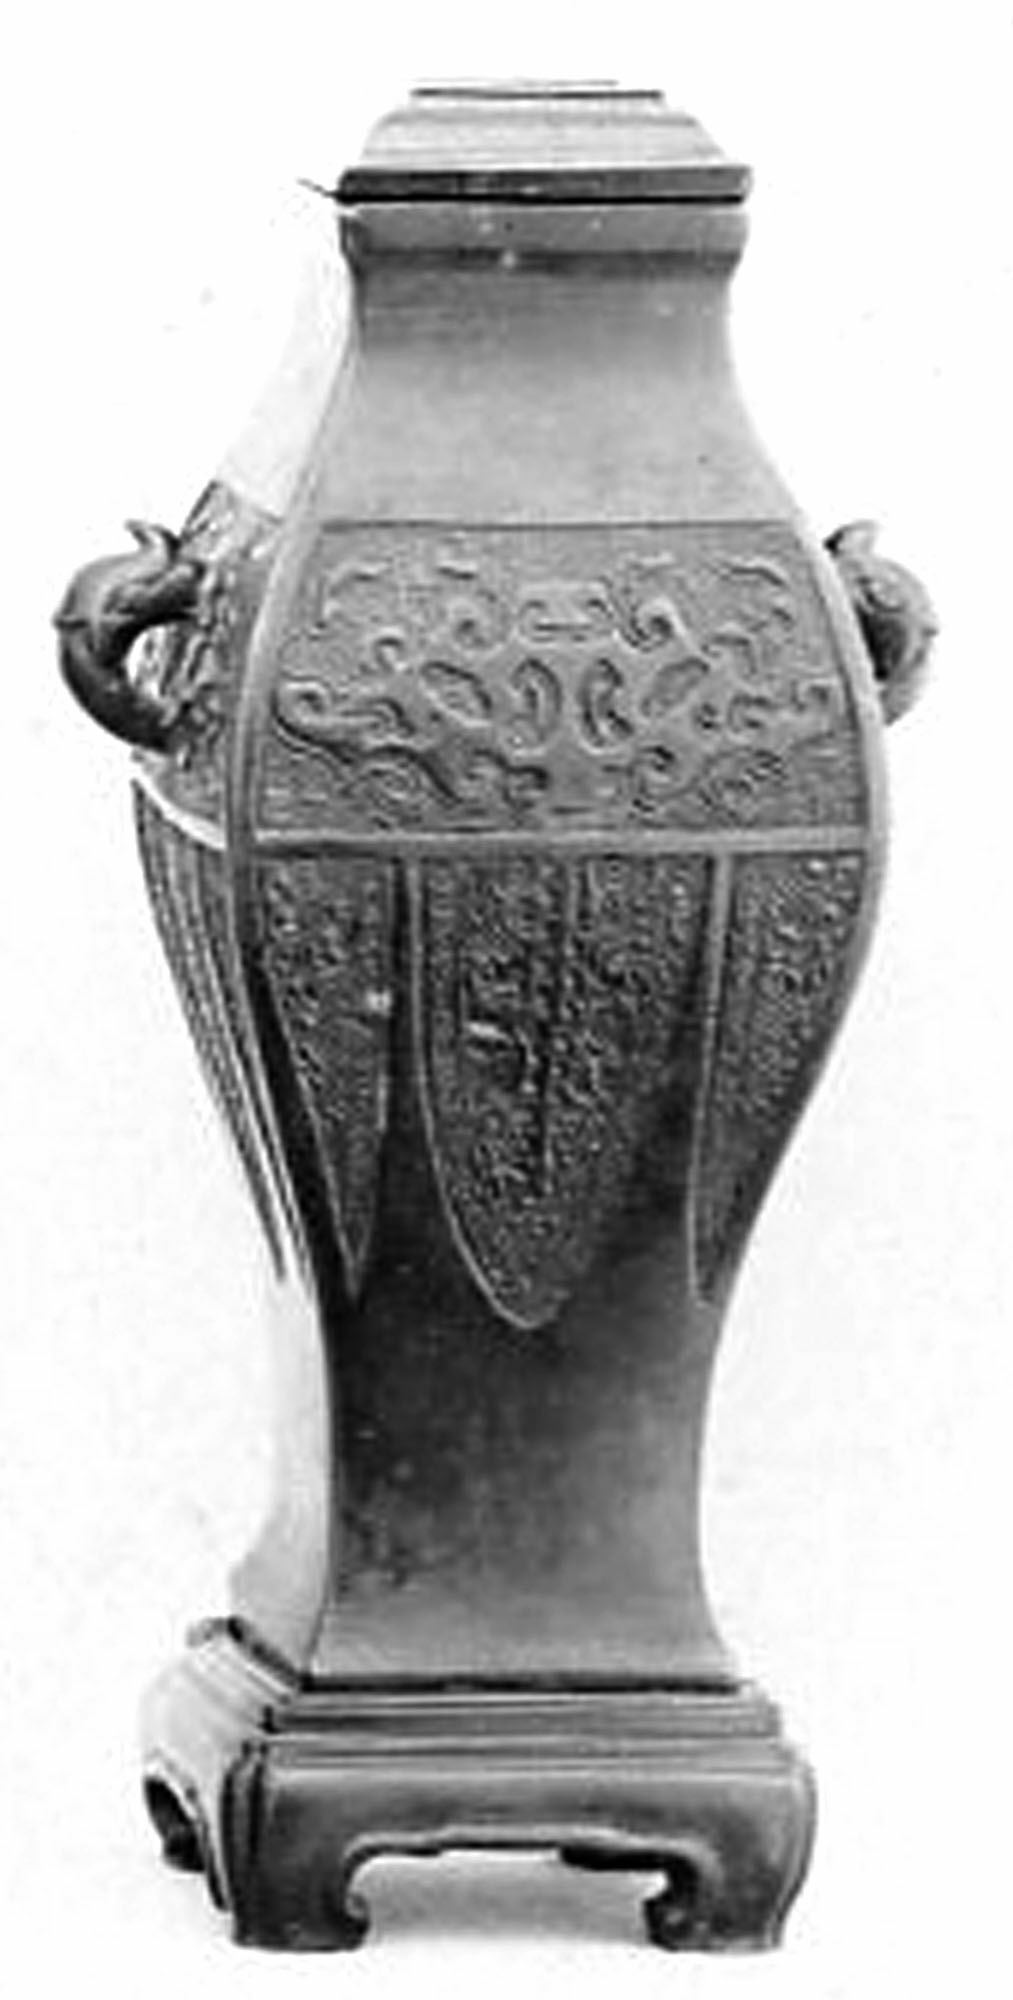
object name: vase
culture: chinese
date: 1662-1722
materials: bronze